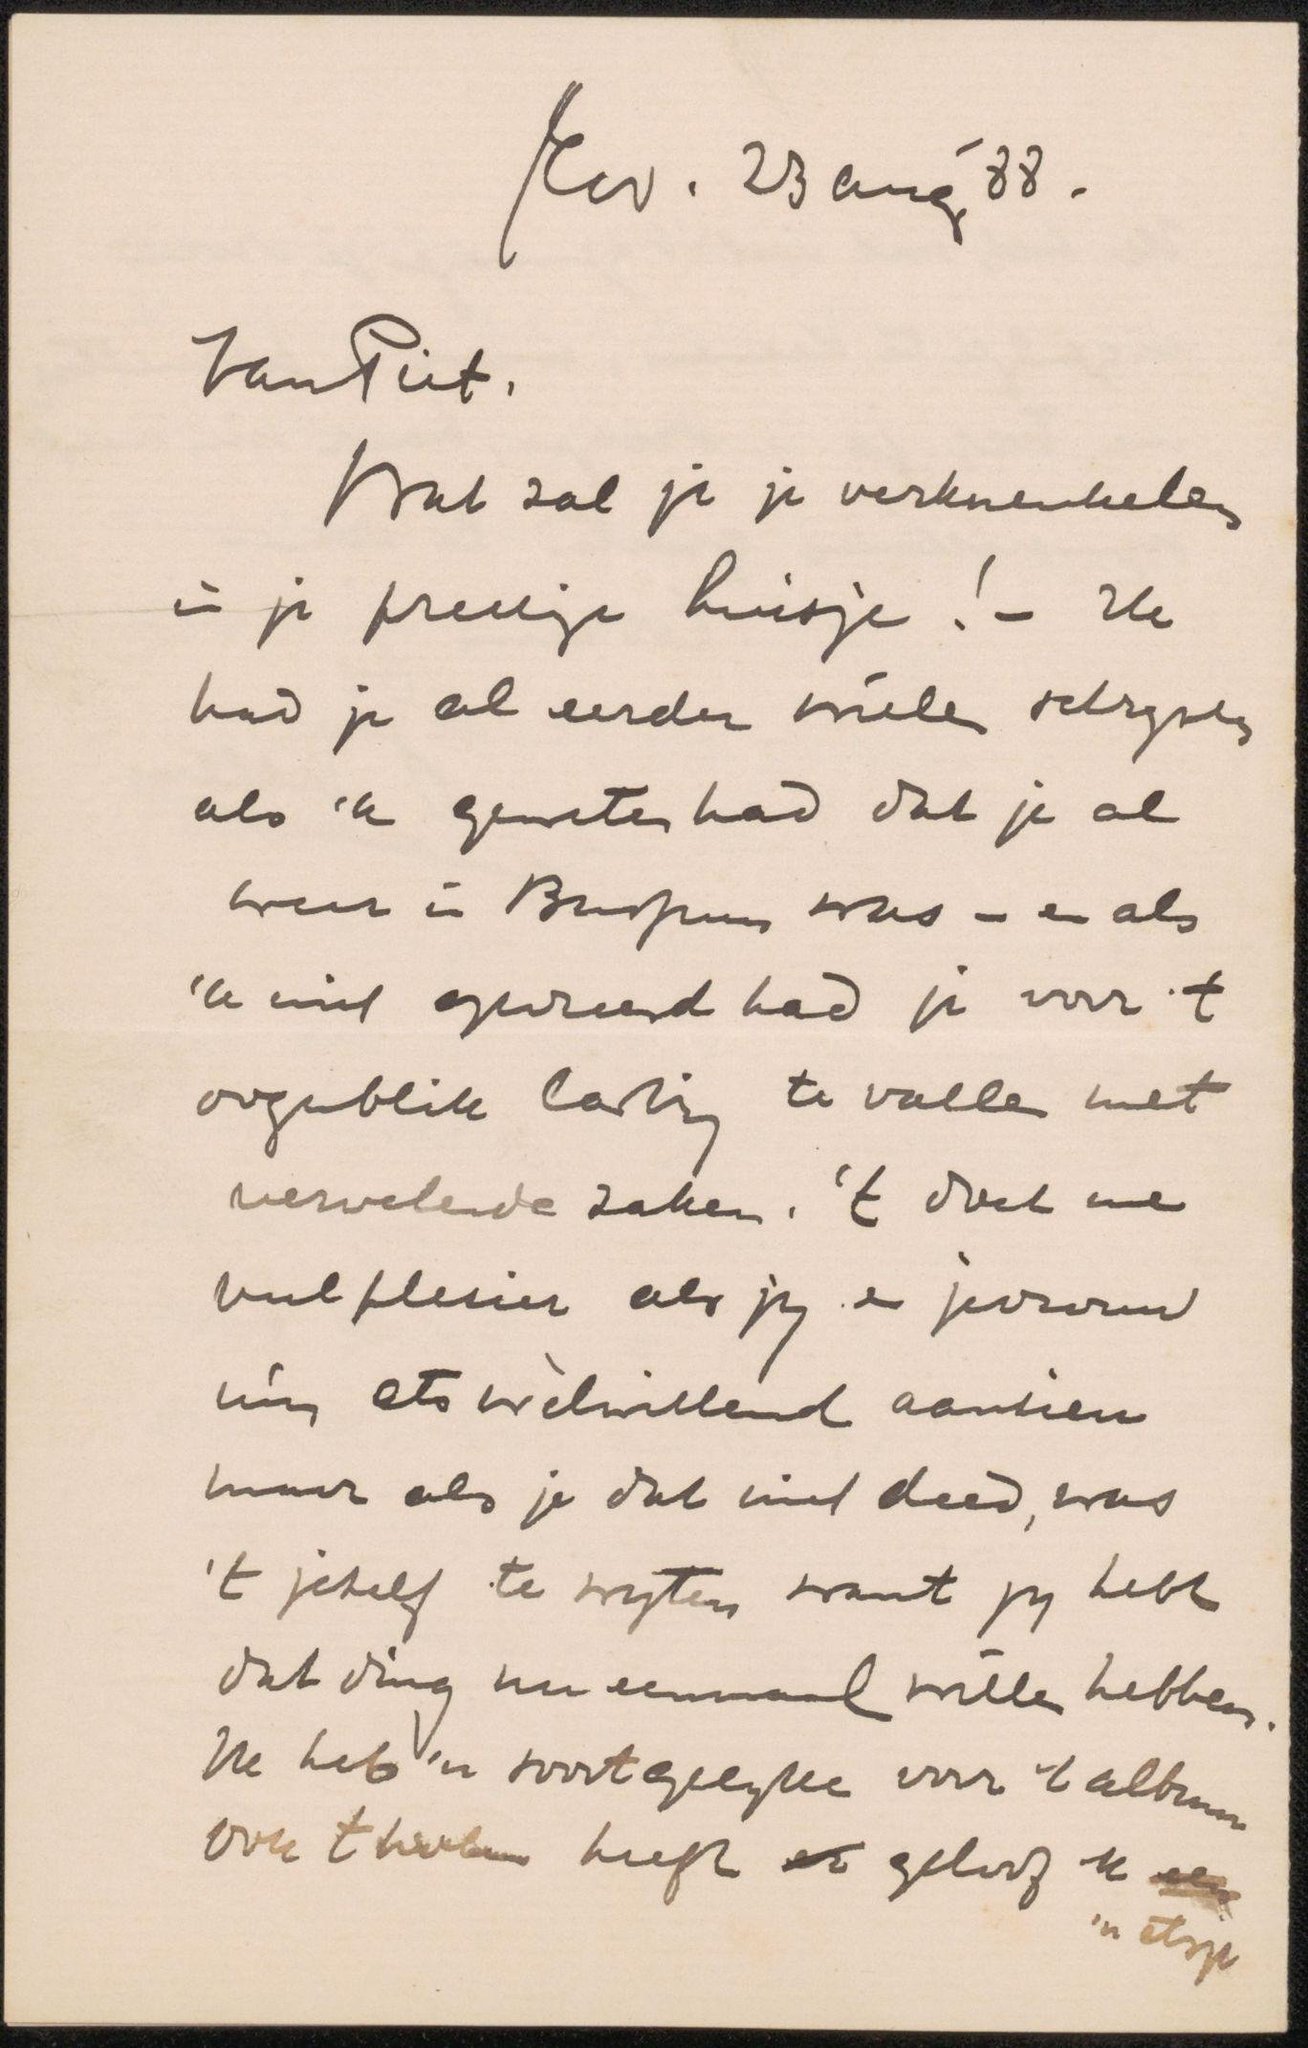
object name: letter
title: Brief aan Jan Veth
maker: willem witsen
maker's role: draughtsman, painter, print maker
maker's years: 1860-1923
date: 1888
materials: ink, paper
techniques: pen, writing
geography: ewijkshoeve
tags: dordrecht, designer, jan veth, the hague, willem bastiaan tholen, haarlem, painter, print maker, draughtsman, anton l. koster, wally moes, martinus mouton, philip zilcken, the graphic arts, money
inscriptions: collector's mark: ‘RPK’, watermark